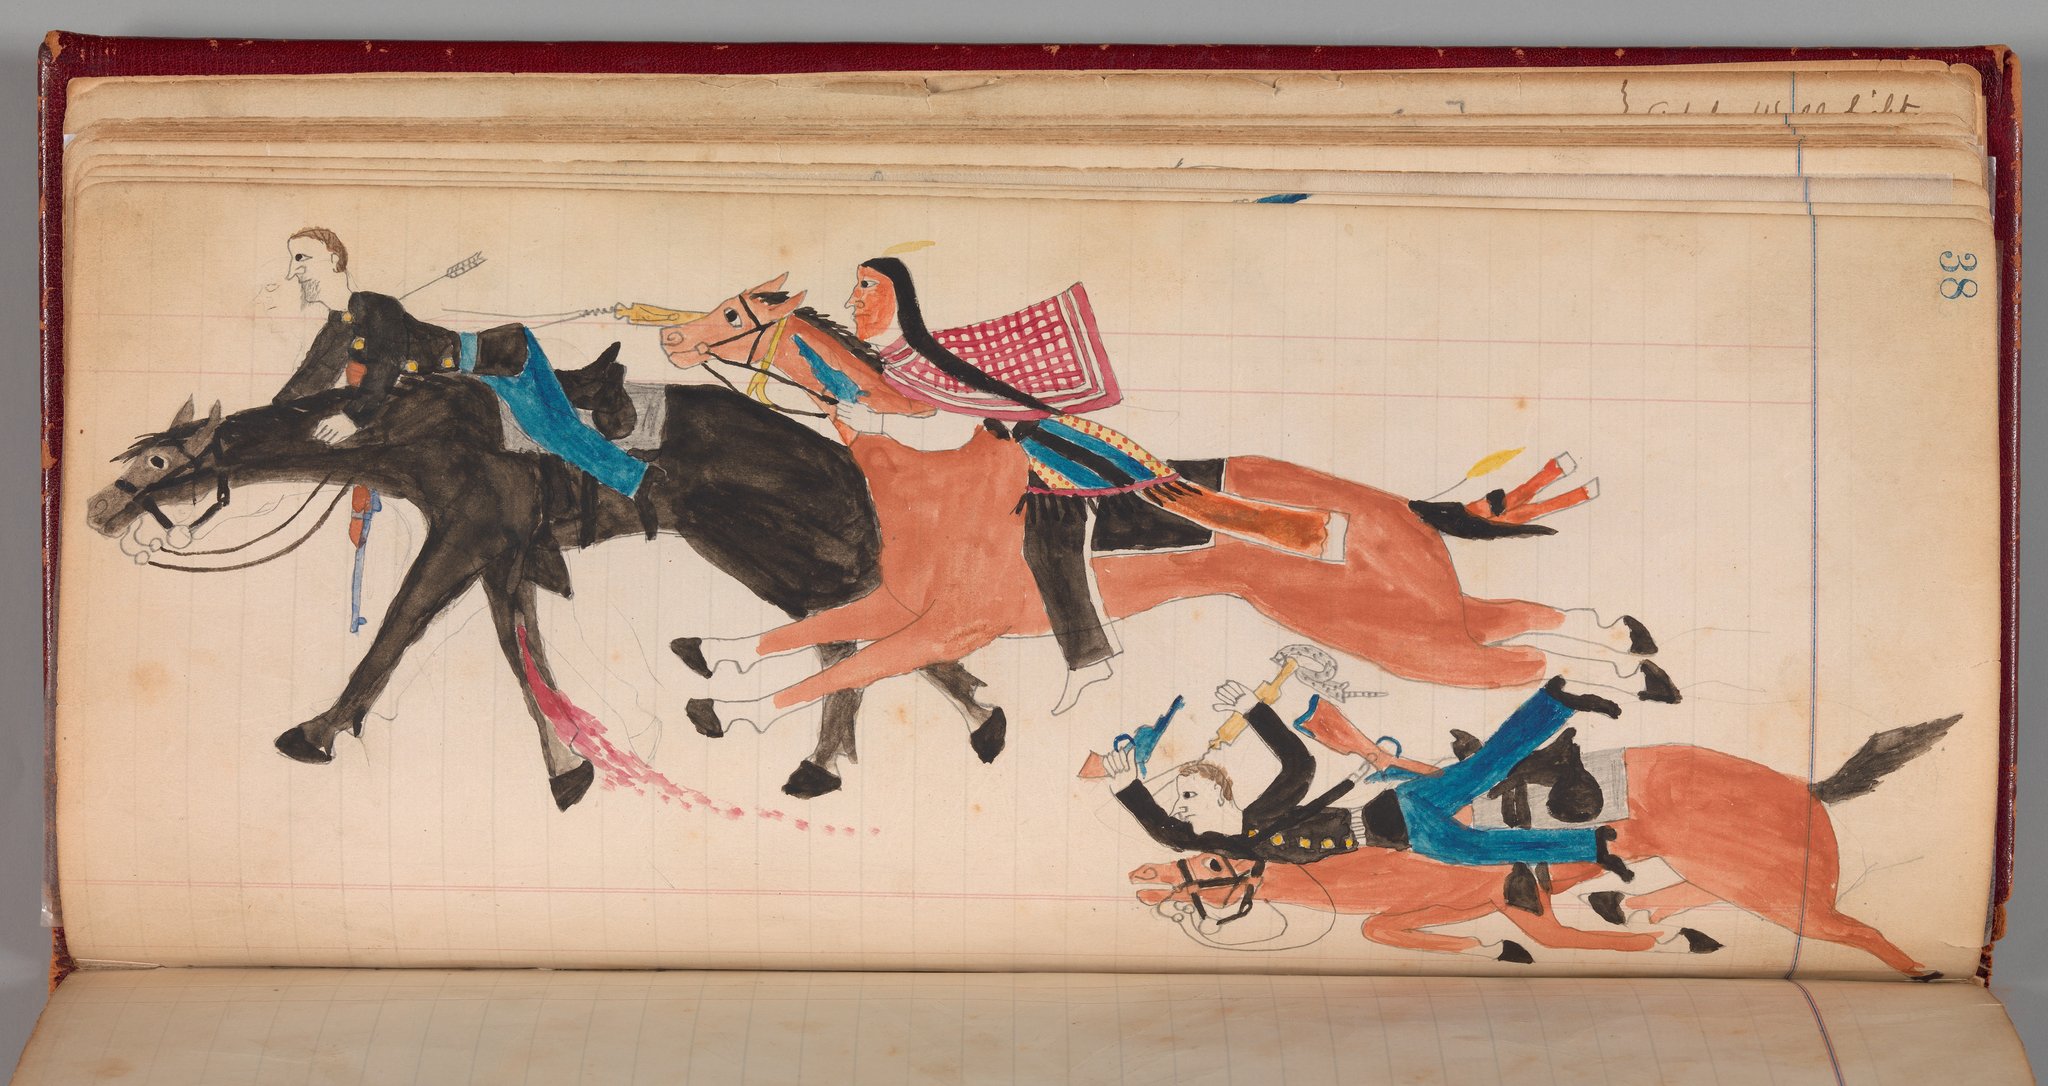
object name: drawing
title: Maffet Ledger: Indian and soldier on horseback, soldier, horse wounded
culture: cheyenne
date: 1874-1881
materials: crayon, graphite, paper, watercolor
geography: united states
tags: soldiers,firearms,men,horses